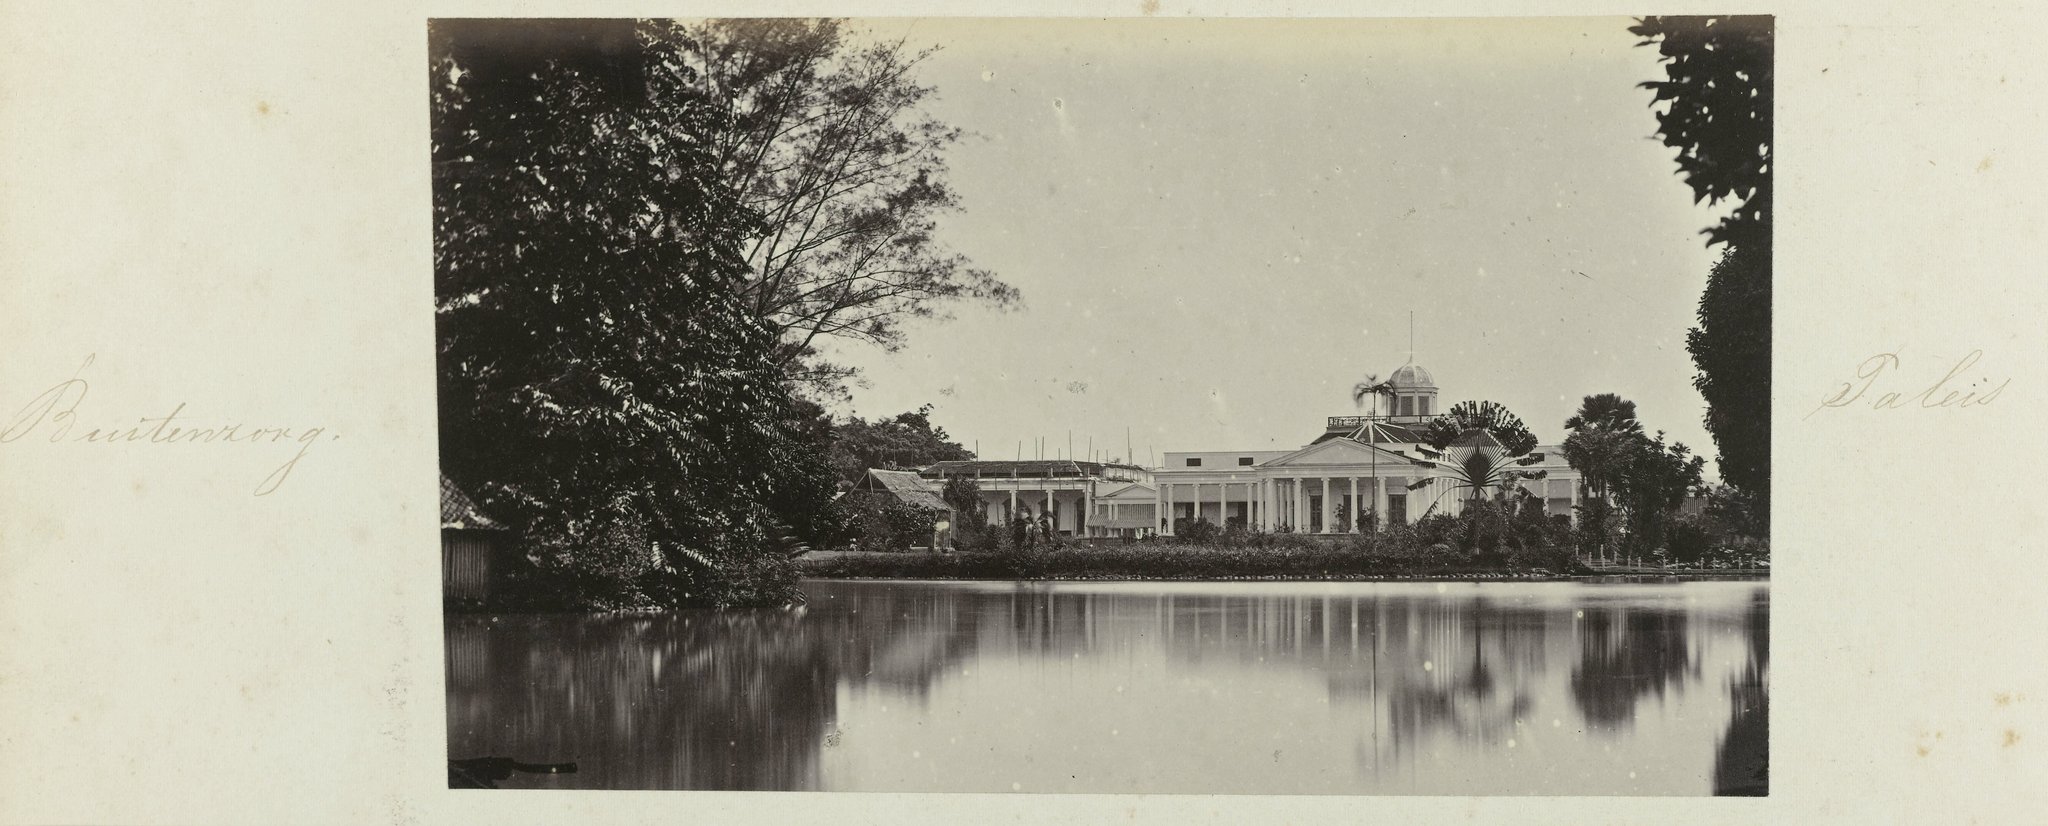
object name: photograph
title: Buitenzorg. Paleis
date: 1863-1869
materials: photographic support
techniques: albumen print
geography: buitenzorg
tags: colonial government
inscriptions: inscription: ‘Buitenzorg. Paleis’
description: Gezicht op het paleis van de Gouverneur-Generaal te Buitenzorg. Onderdeel van het groene fotoalbum met foto's van Java, uit het bezit van apotheker Specht-Grijp, die in 1865 vanuit Batavia naar Nederland terugkeerde.